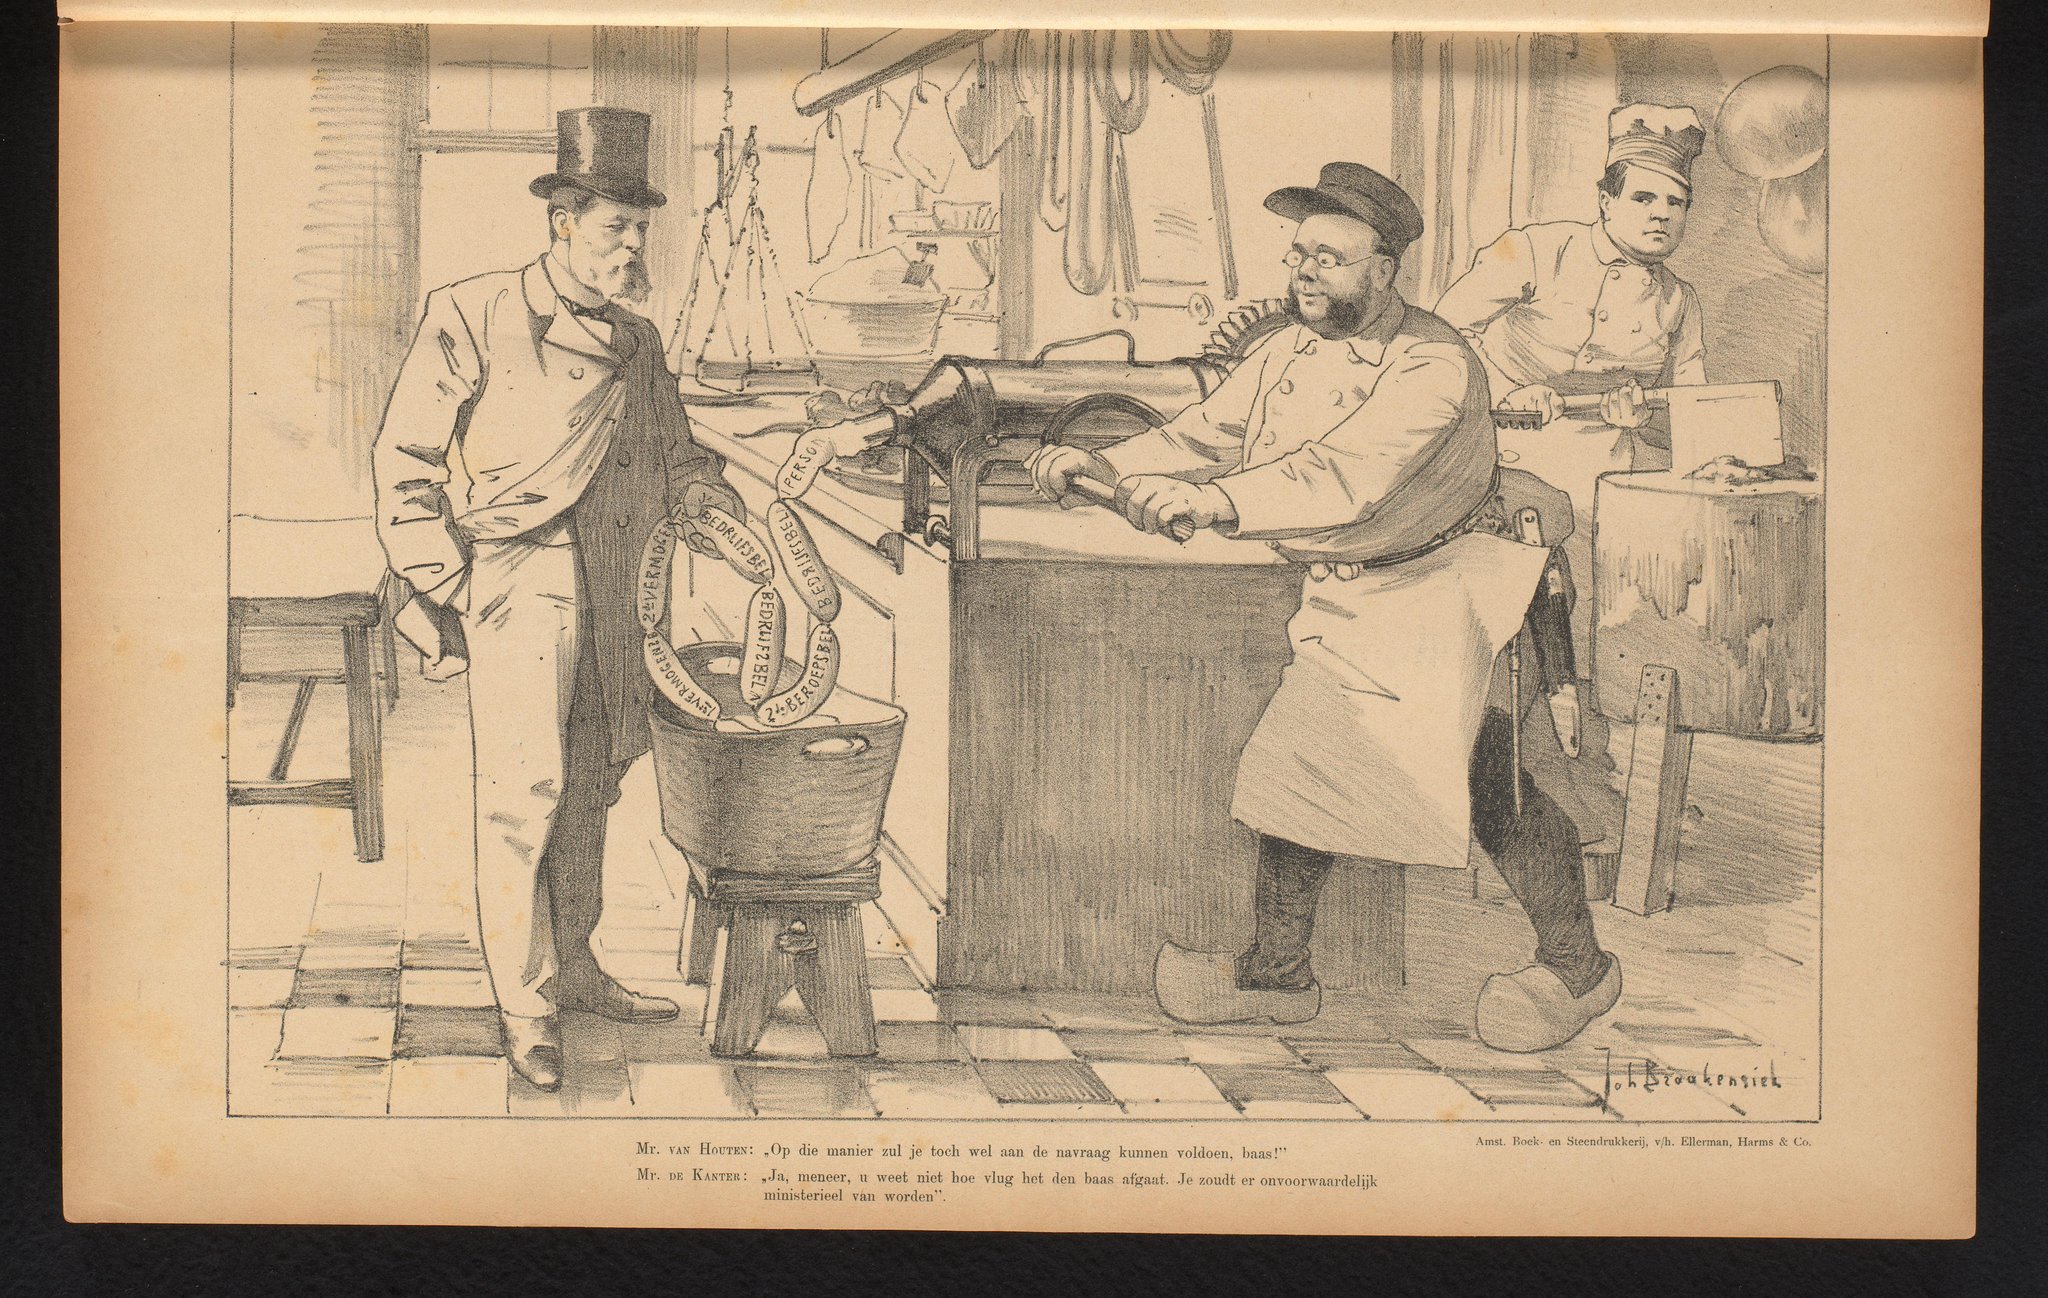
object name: cartoon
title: De ministerieele (w)etworst-molen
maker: johan braakensiek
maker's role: draughtsman, print maker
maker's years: 1858-1940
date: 1893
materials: paper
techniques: lithograph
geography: amsterdam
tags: amsterdam, politician, nicolaas gerard pierson, brielle, haarlem, samuel van houten, minister ~ government, butcher, slaughterman, sausage, political caricatures and satires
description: Minister van Financiën Nicolaas Pierson als een slager die tot tevredenheid van de Kamerleden Samuel van Houten en Hubert de Kanter een grote hoeveelheid worsten uit de gehaktmolen draait.